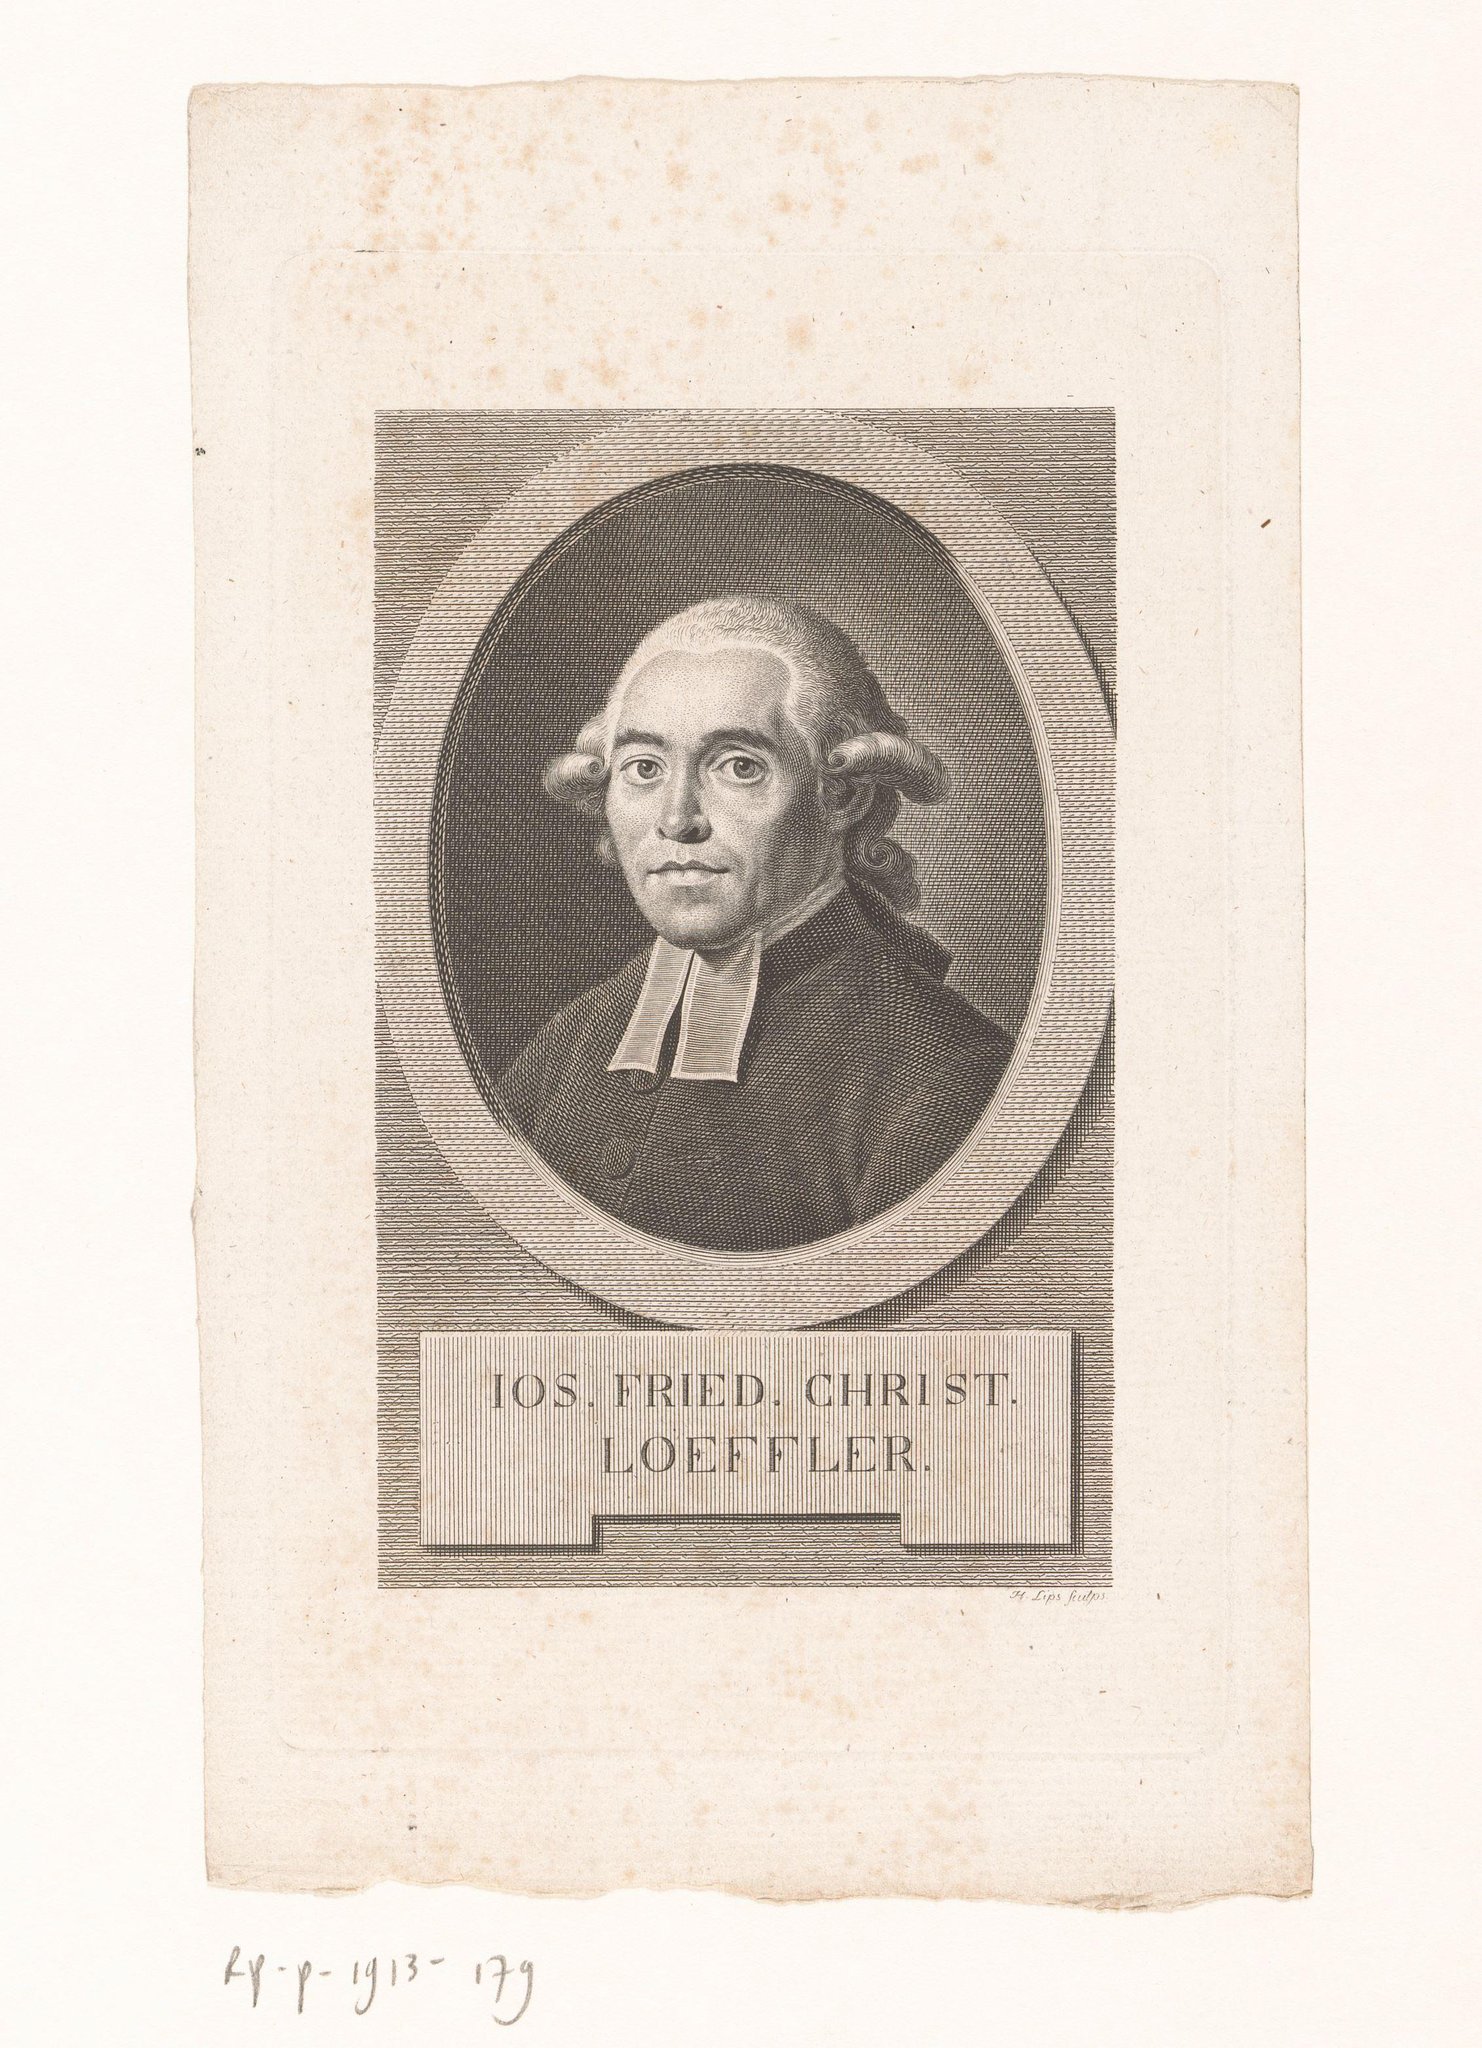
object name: print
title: Portret van Josias Friedrich Christian Löffler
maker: johann heinrich lips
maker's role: draughtsman, painter, print maker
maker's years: 1758-1817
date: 1768-1817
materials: paper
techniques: engraving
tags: theologian, historical persons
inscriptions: collector's mark: Lugt 2228